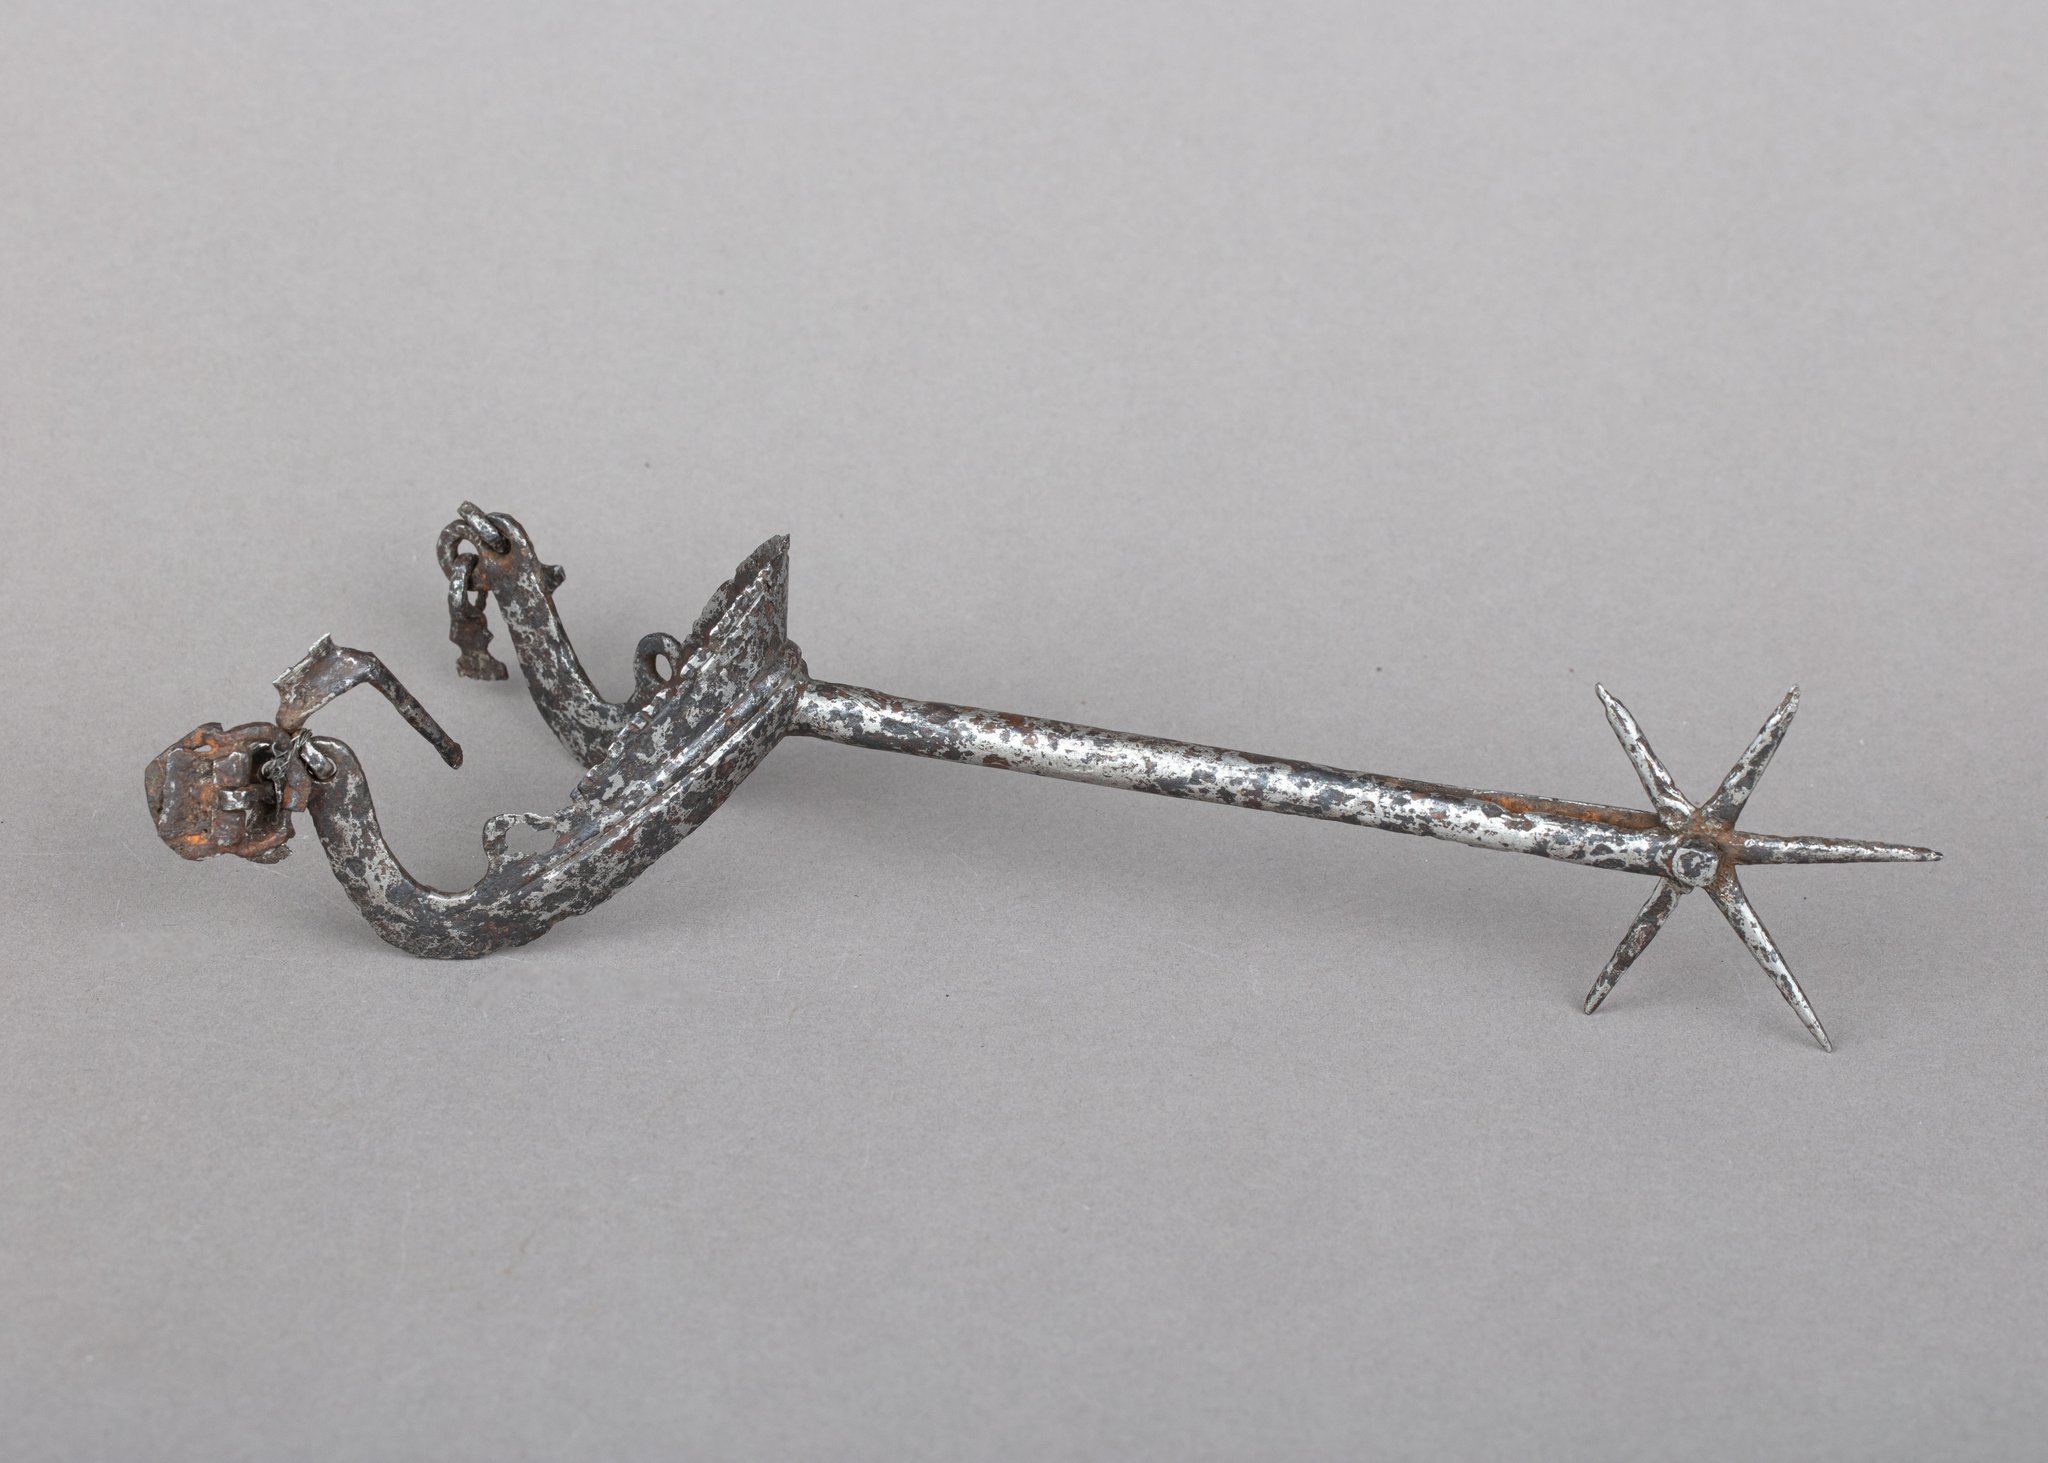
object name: spur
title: Rowel Spur (Left)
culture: german or bohemian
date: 1401-1500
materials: metal alloy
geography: czech republic